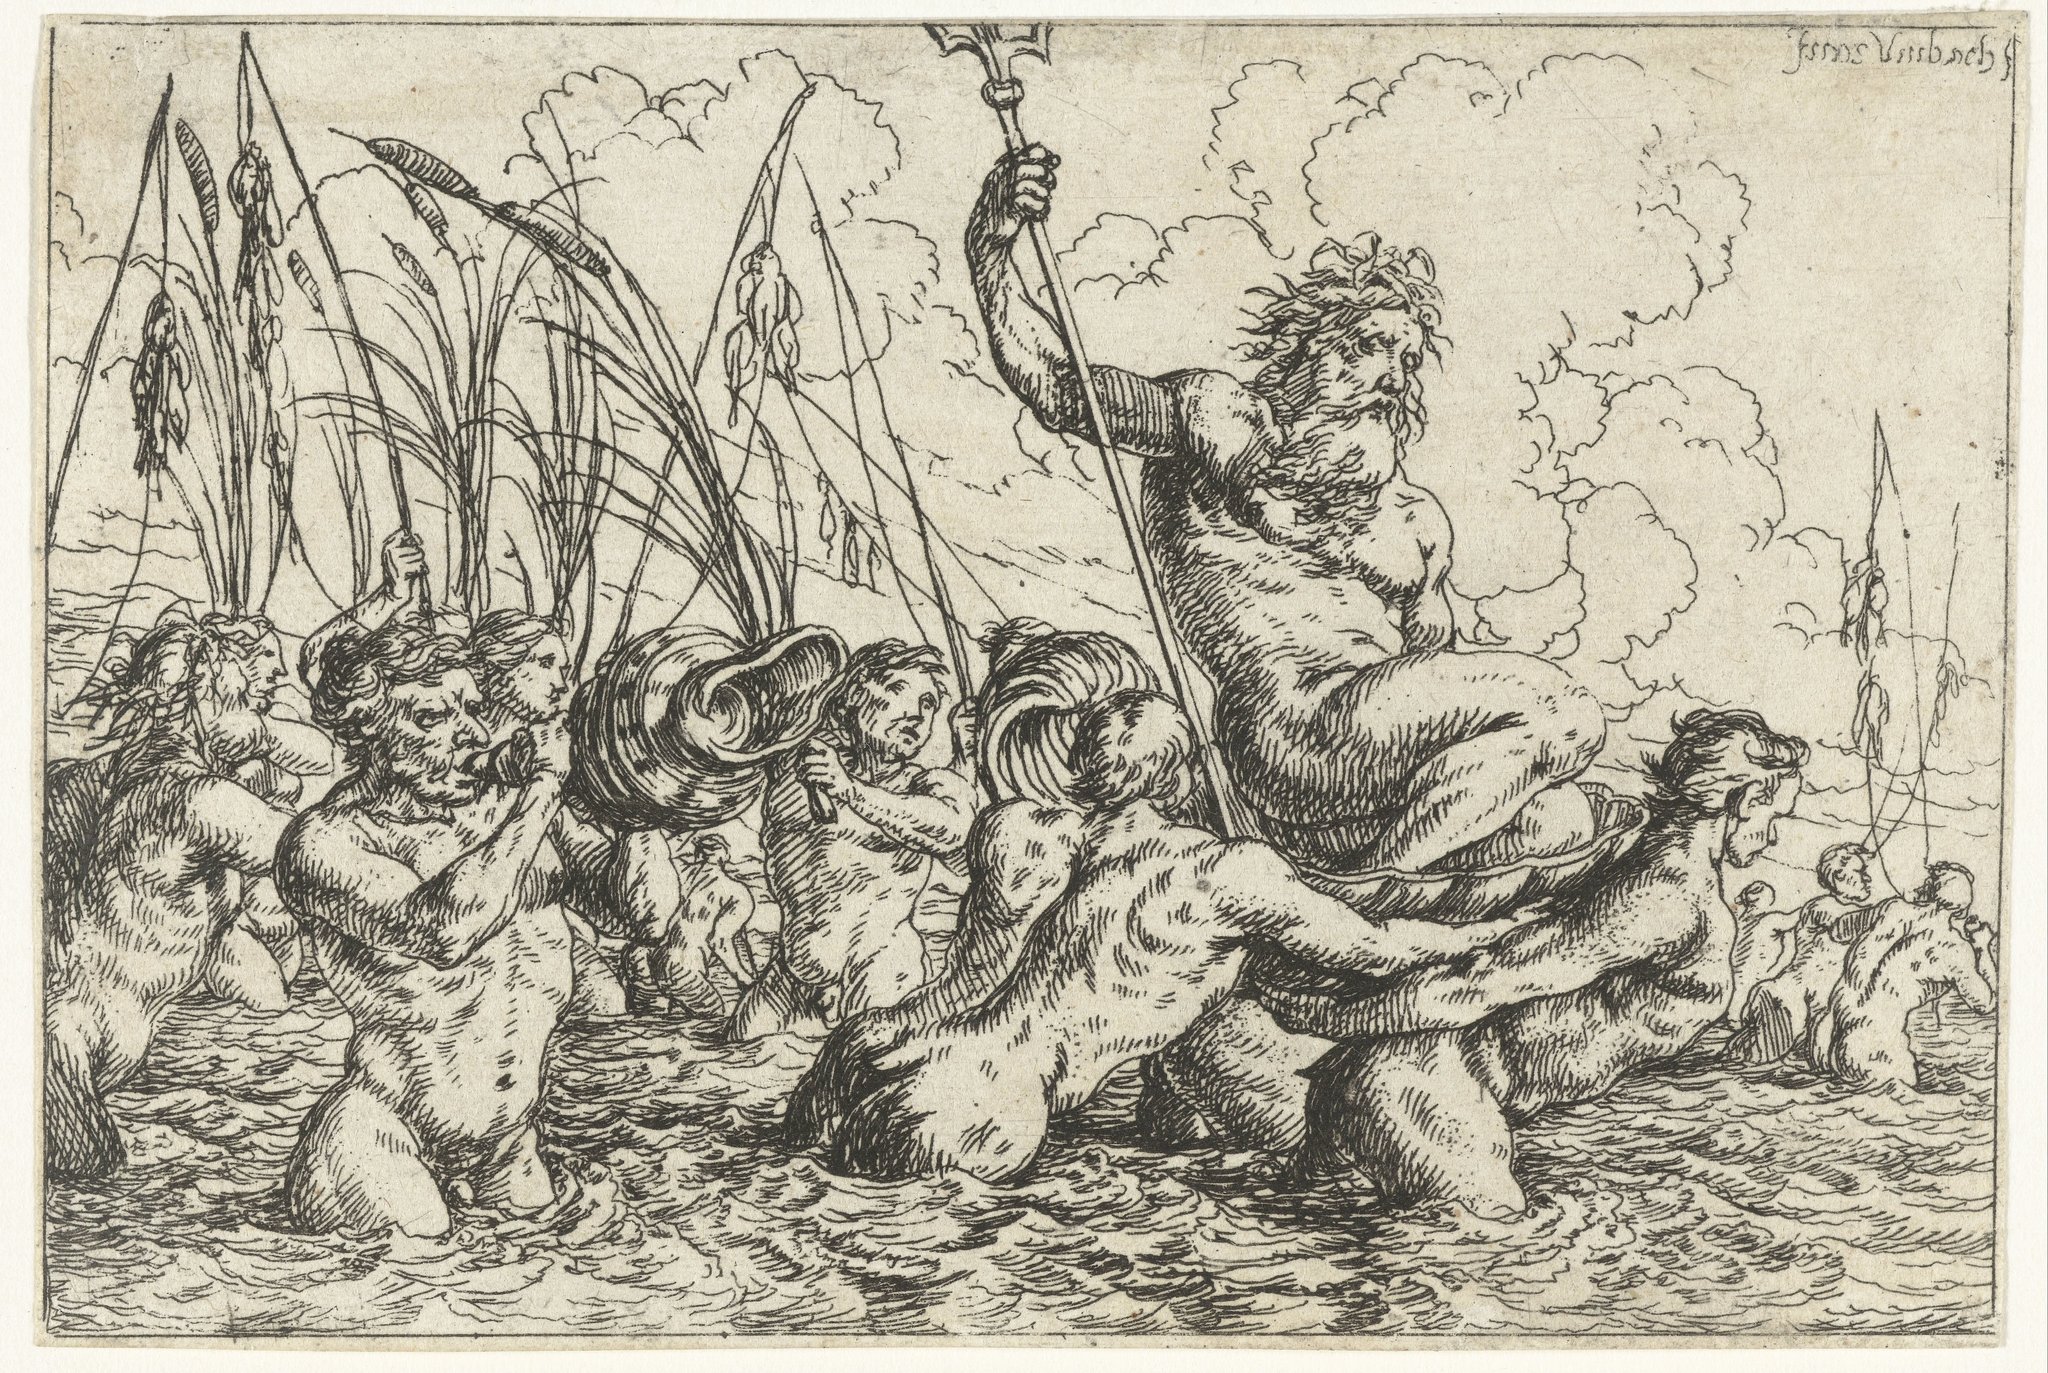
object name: print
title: Triomf van Neptunus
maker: jonas umbach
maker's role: print maker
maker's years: 1624-1693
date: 1634-1690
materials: paper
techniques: etching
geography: augsburg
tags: triumph of neptune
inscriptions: collector's mark: Lugt 2228, collector's mark: Lugt 2760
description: Neptunus, zittend in een schelp, gevolgd door tritons en zeegoden.